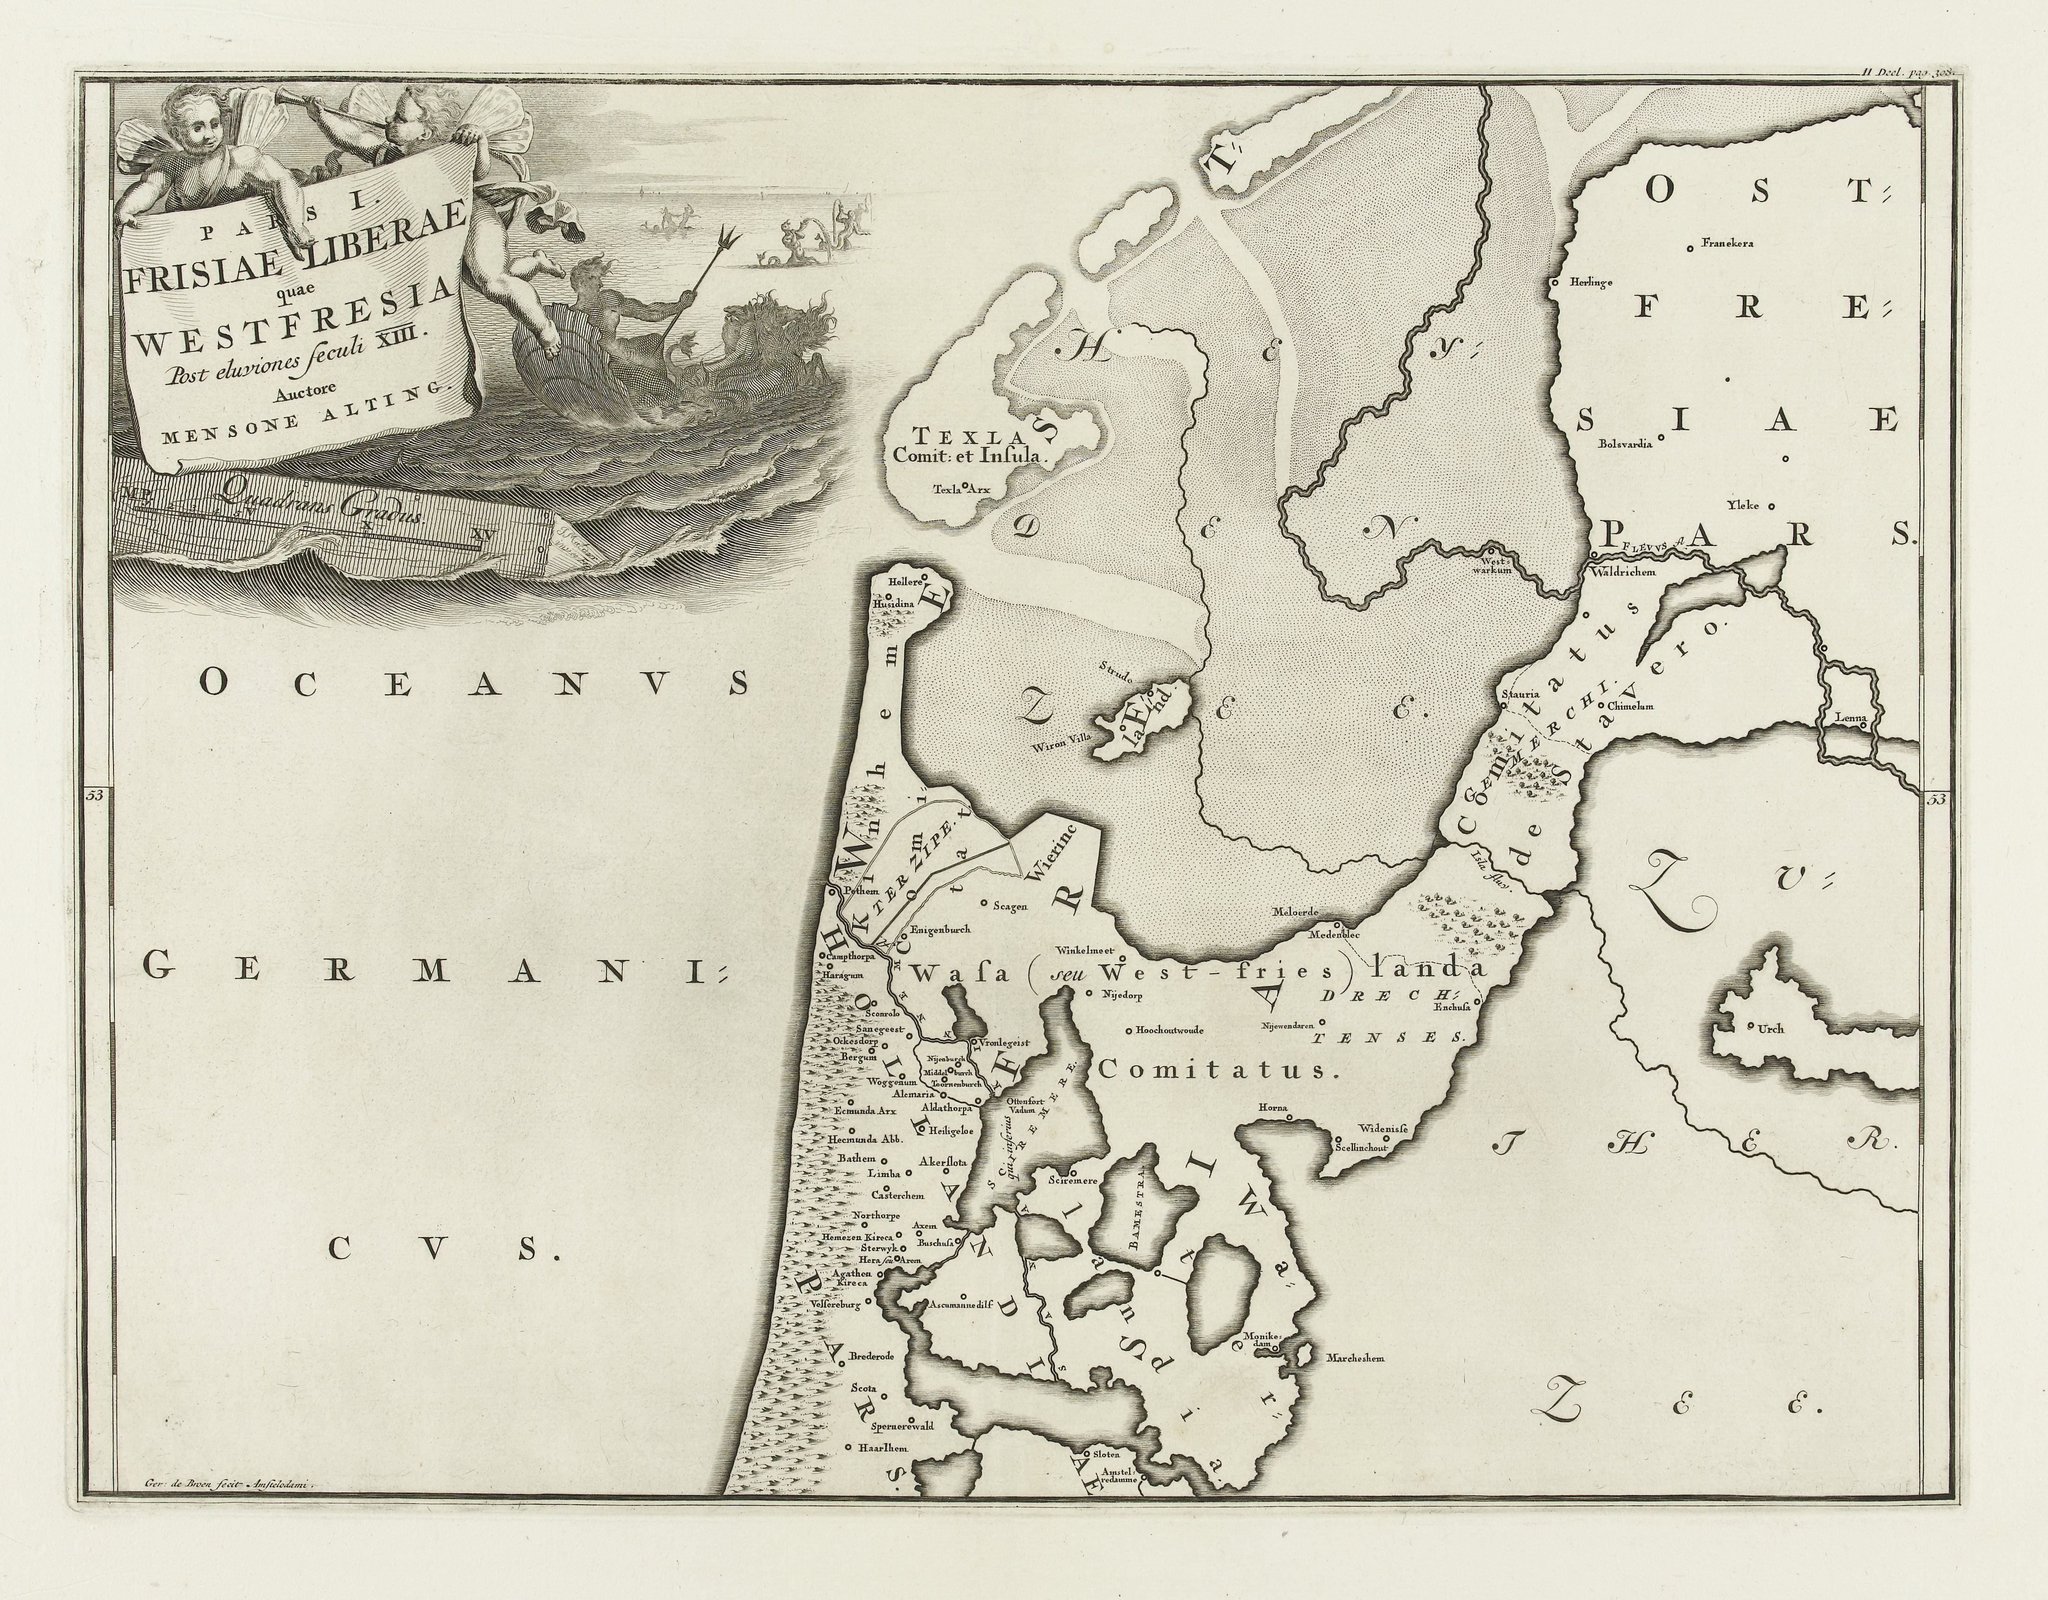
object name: print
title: Pars I Frisiae Liberae quae WestFresia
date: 1695-1700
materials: paper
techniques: engraving, etching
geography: amsterdam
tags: maps of separate countries or regions, netherlands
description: Kaart van West-Friesland. Maakt deel uit van 16 kaarten van het land van de Bataven en de Friezen eerst vervaardigd voor en opgenomen in M. Alting, Descriptio ant. agri Batavi et Frisii, s. notitia Germ. infer., 2 delen, 1697-1700. Hergebruikt in F. Halma, Tooneel der Vereenigde Nederlanden en onderhorige landschappen, geopent in een algemeen historisch, genealogisch, geographisch en staatkundig woordenboek, 2 delen, 1725. Volgens opschrift geplaatst in: Deel II, pag. 308.